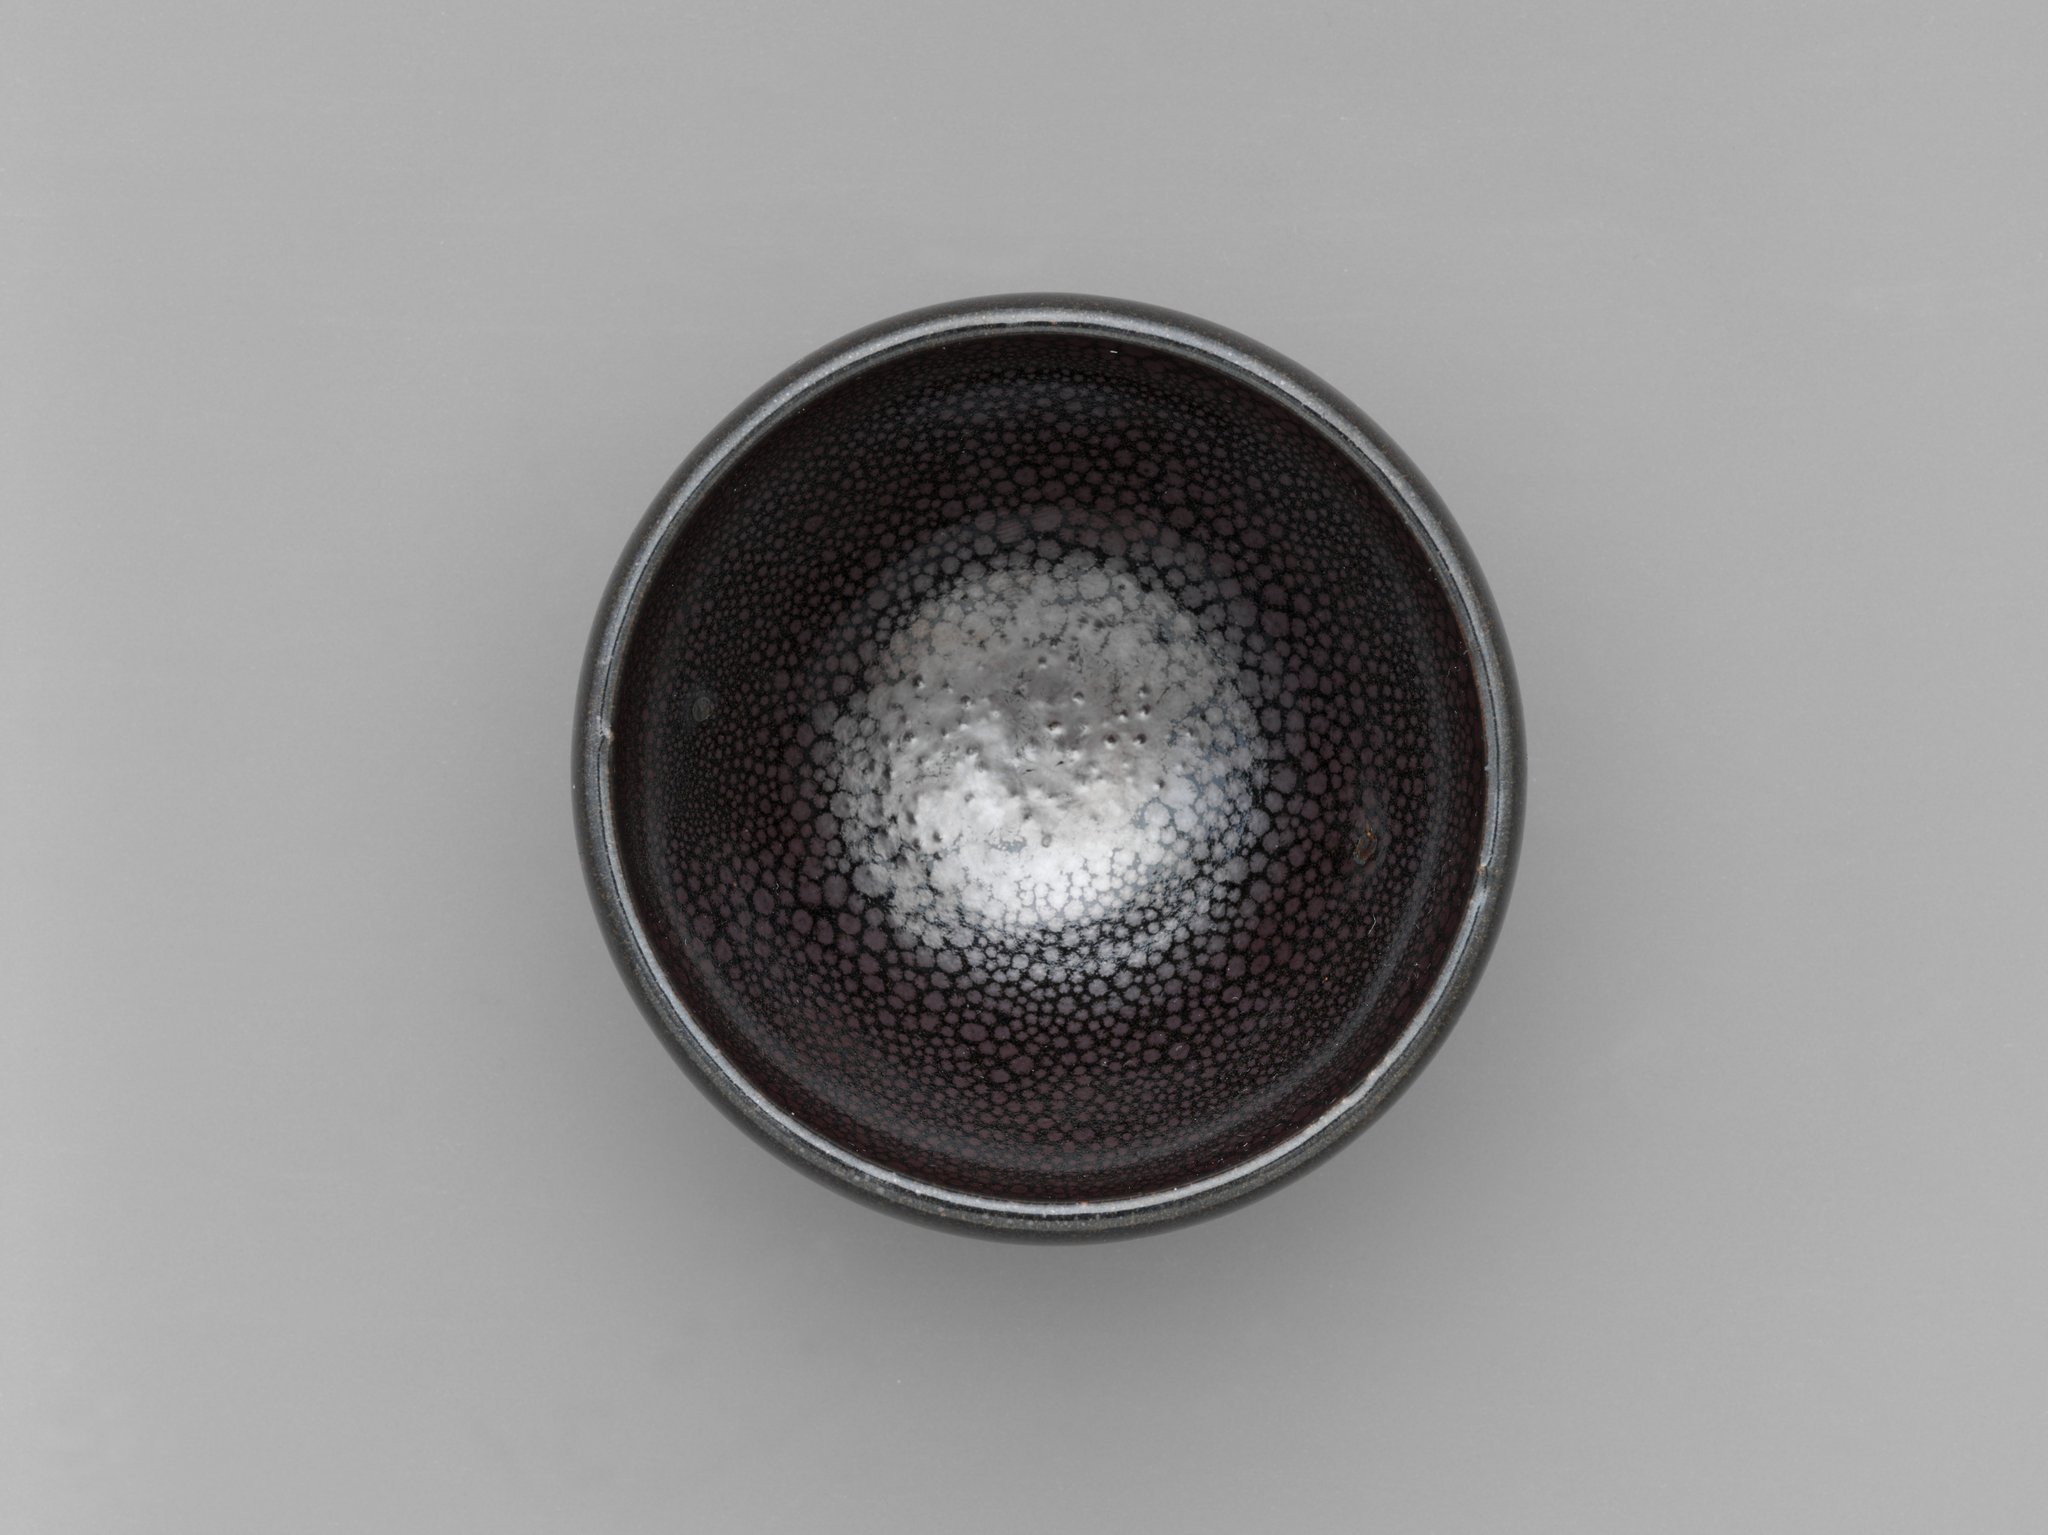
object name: bowl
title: Bowl with “Oil-Spot” Design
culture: chinese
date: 1101-1300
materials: glaze, iron, stoneware